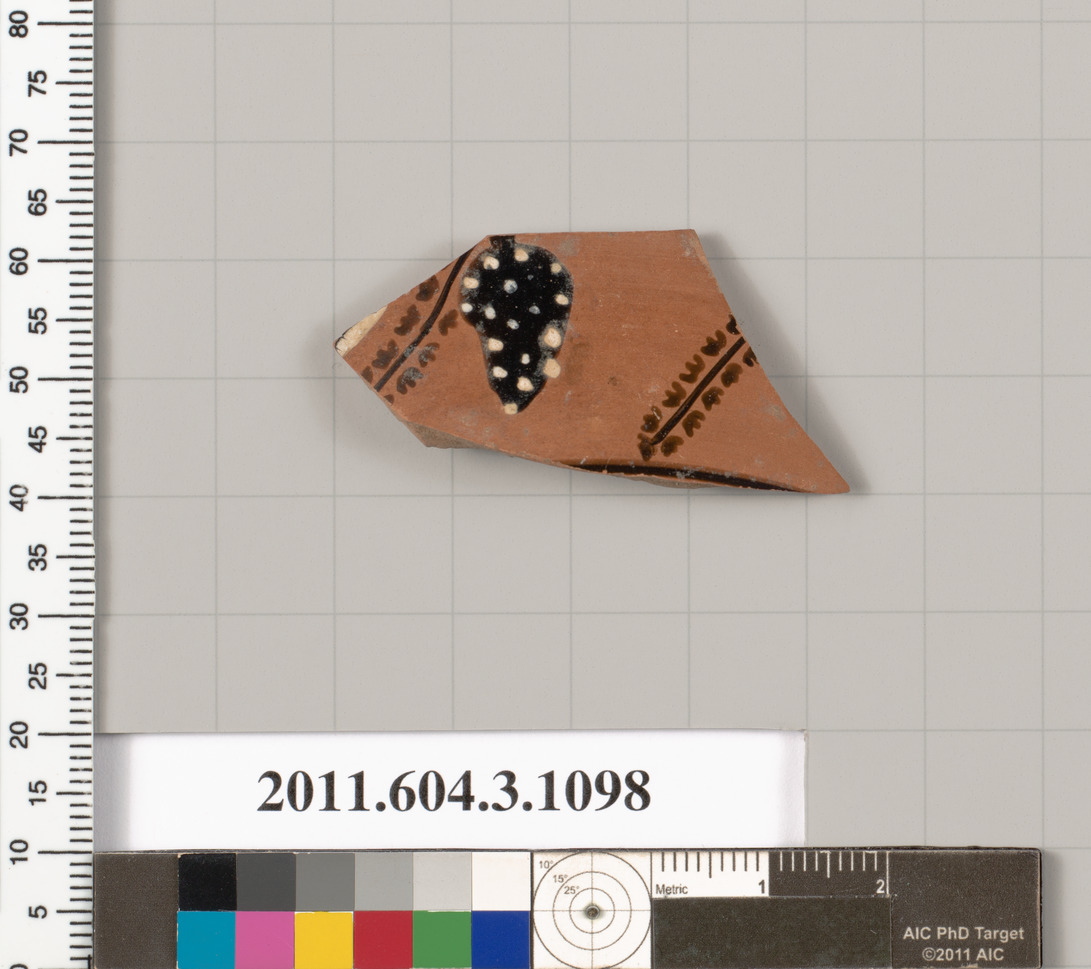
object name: mastoid or kyathos fragment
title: Terracotta fragment of a mastoid (drinking cup with narrow base) or a kyathos (cup-shaped ladle)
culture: greek, attic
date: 534-468 BCE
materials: terracotta